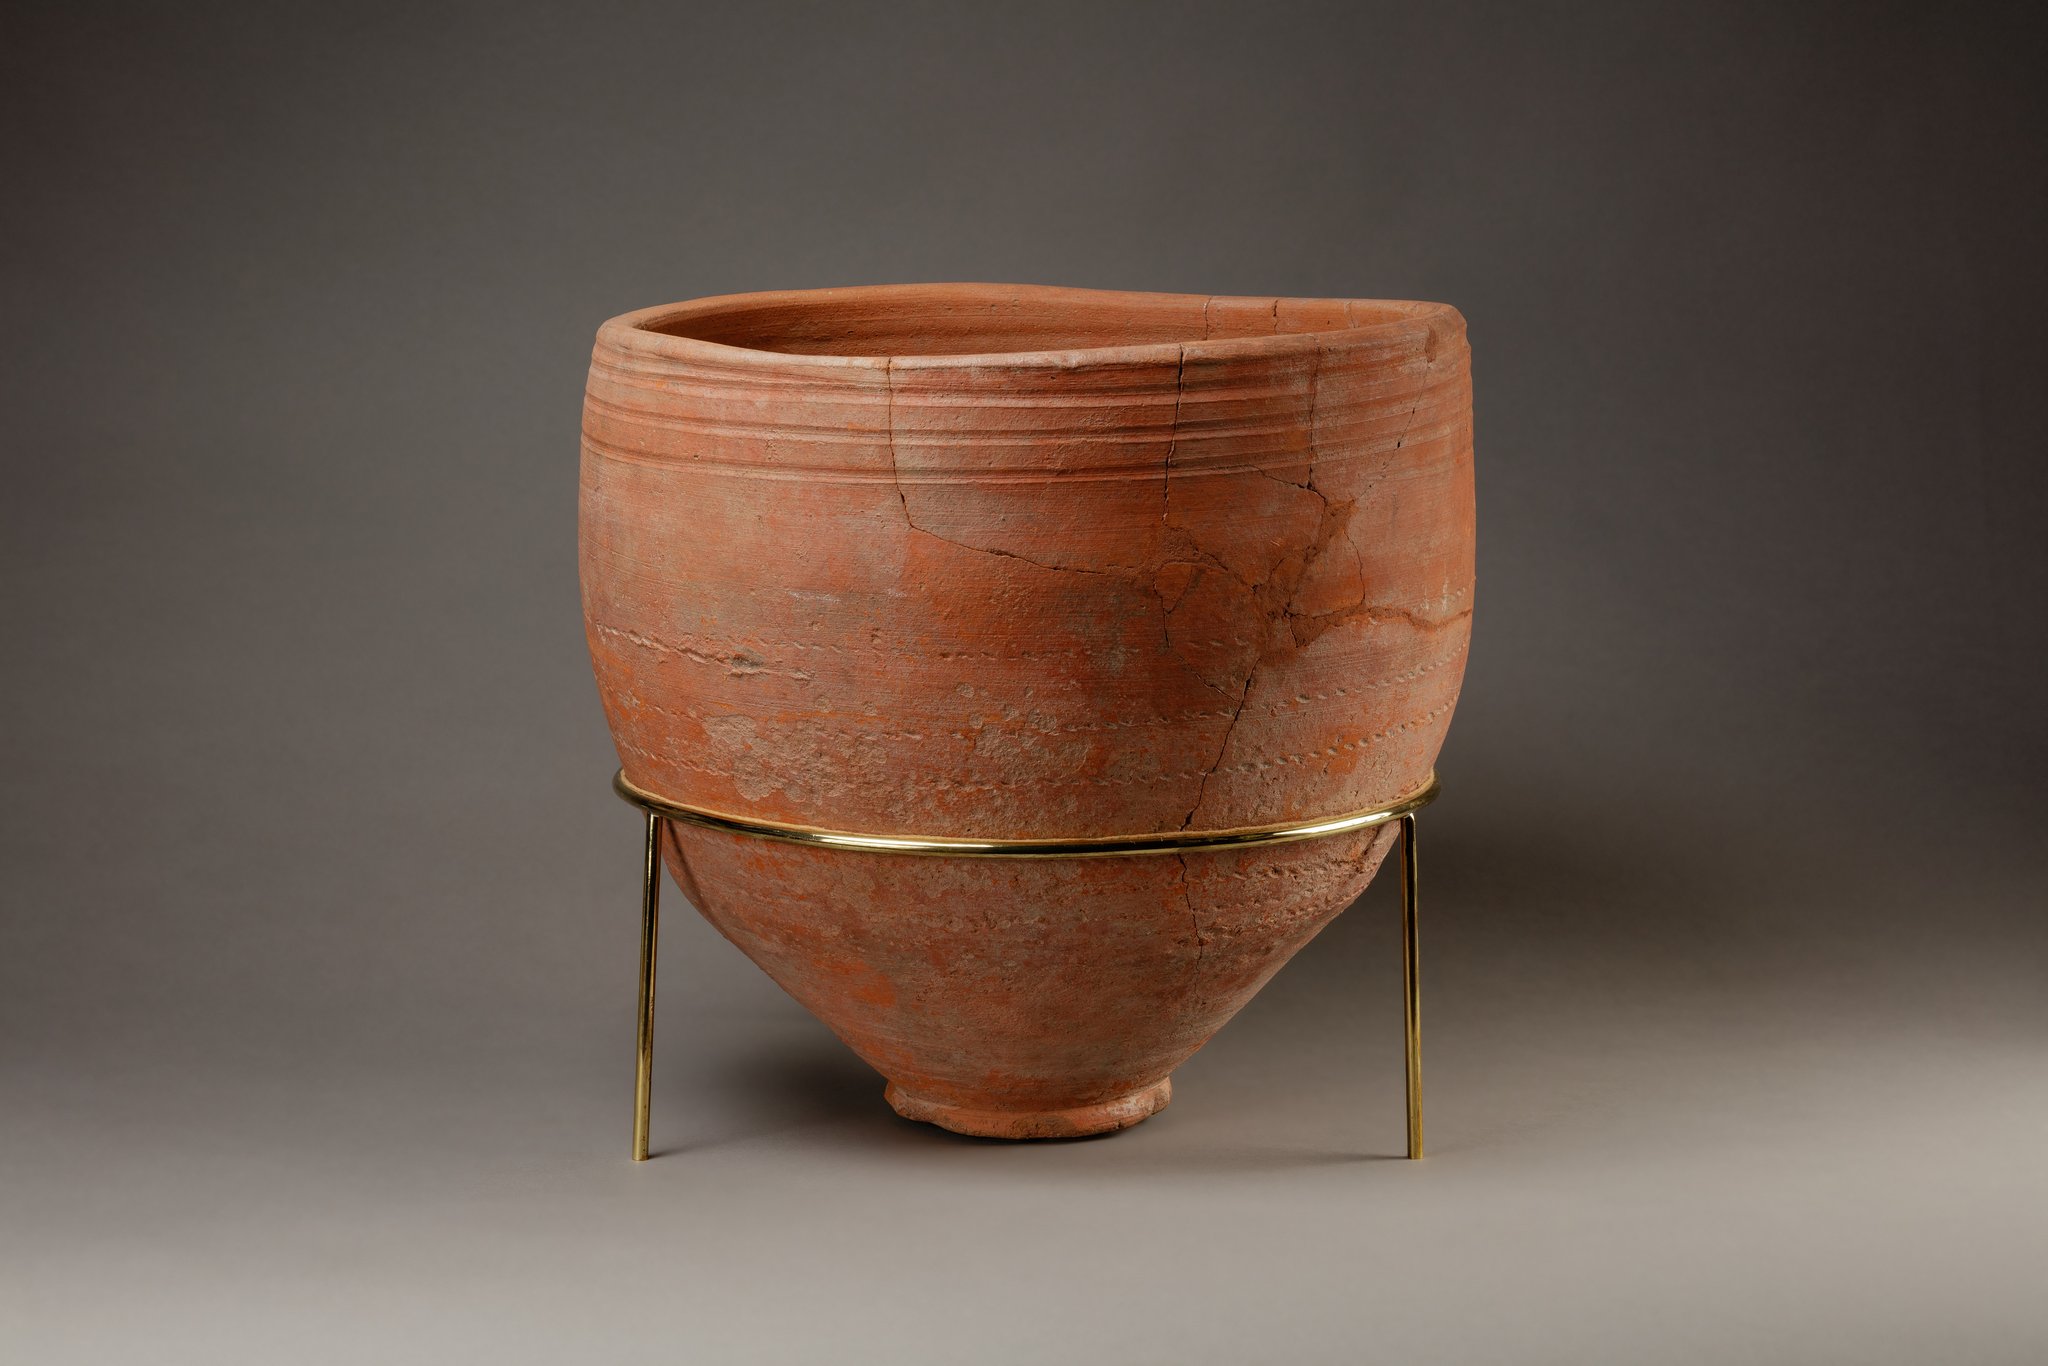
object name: bowl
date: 664-332 BCE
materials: pottery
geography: egypt